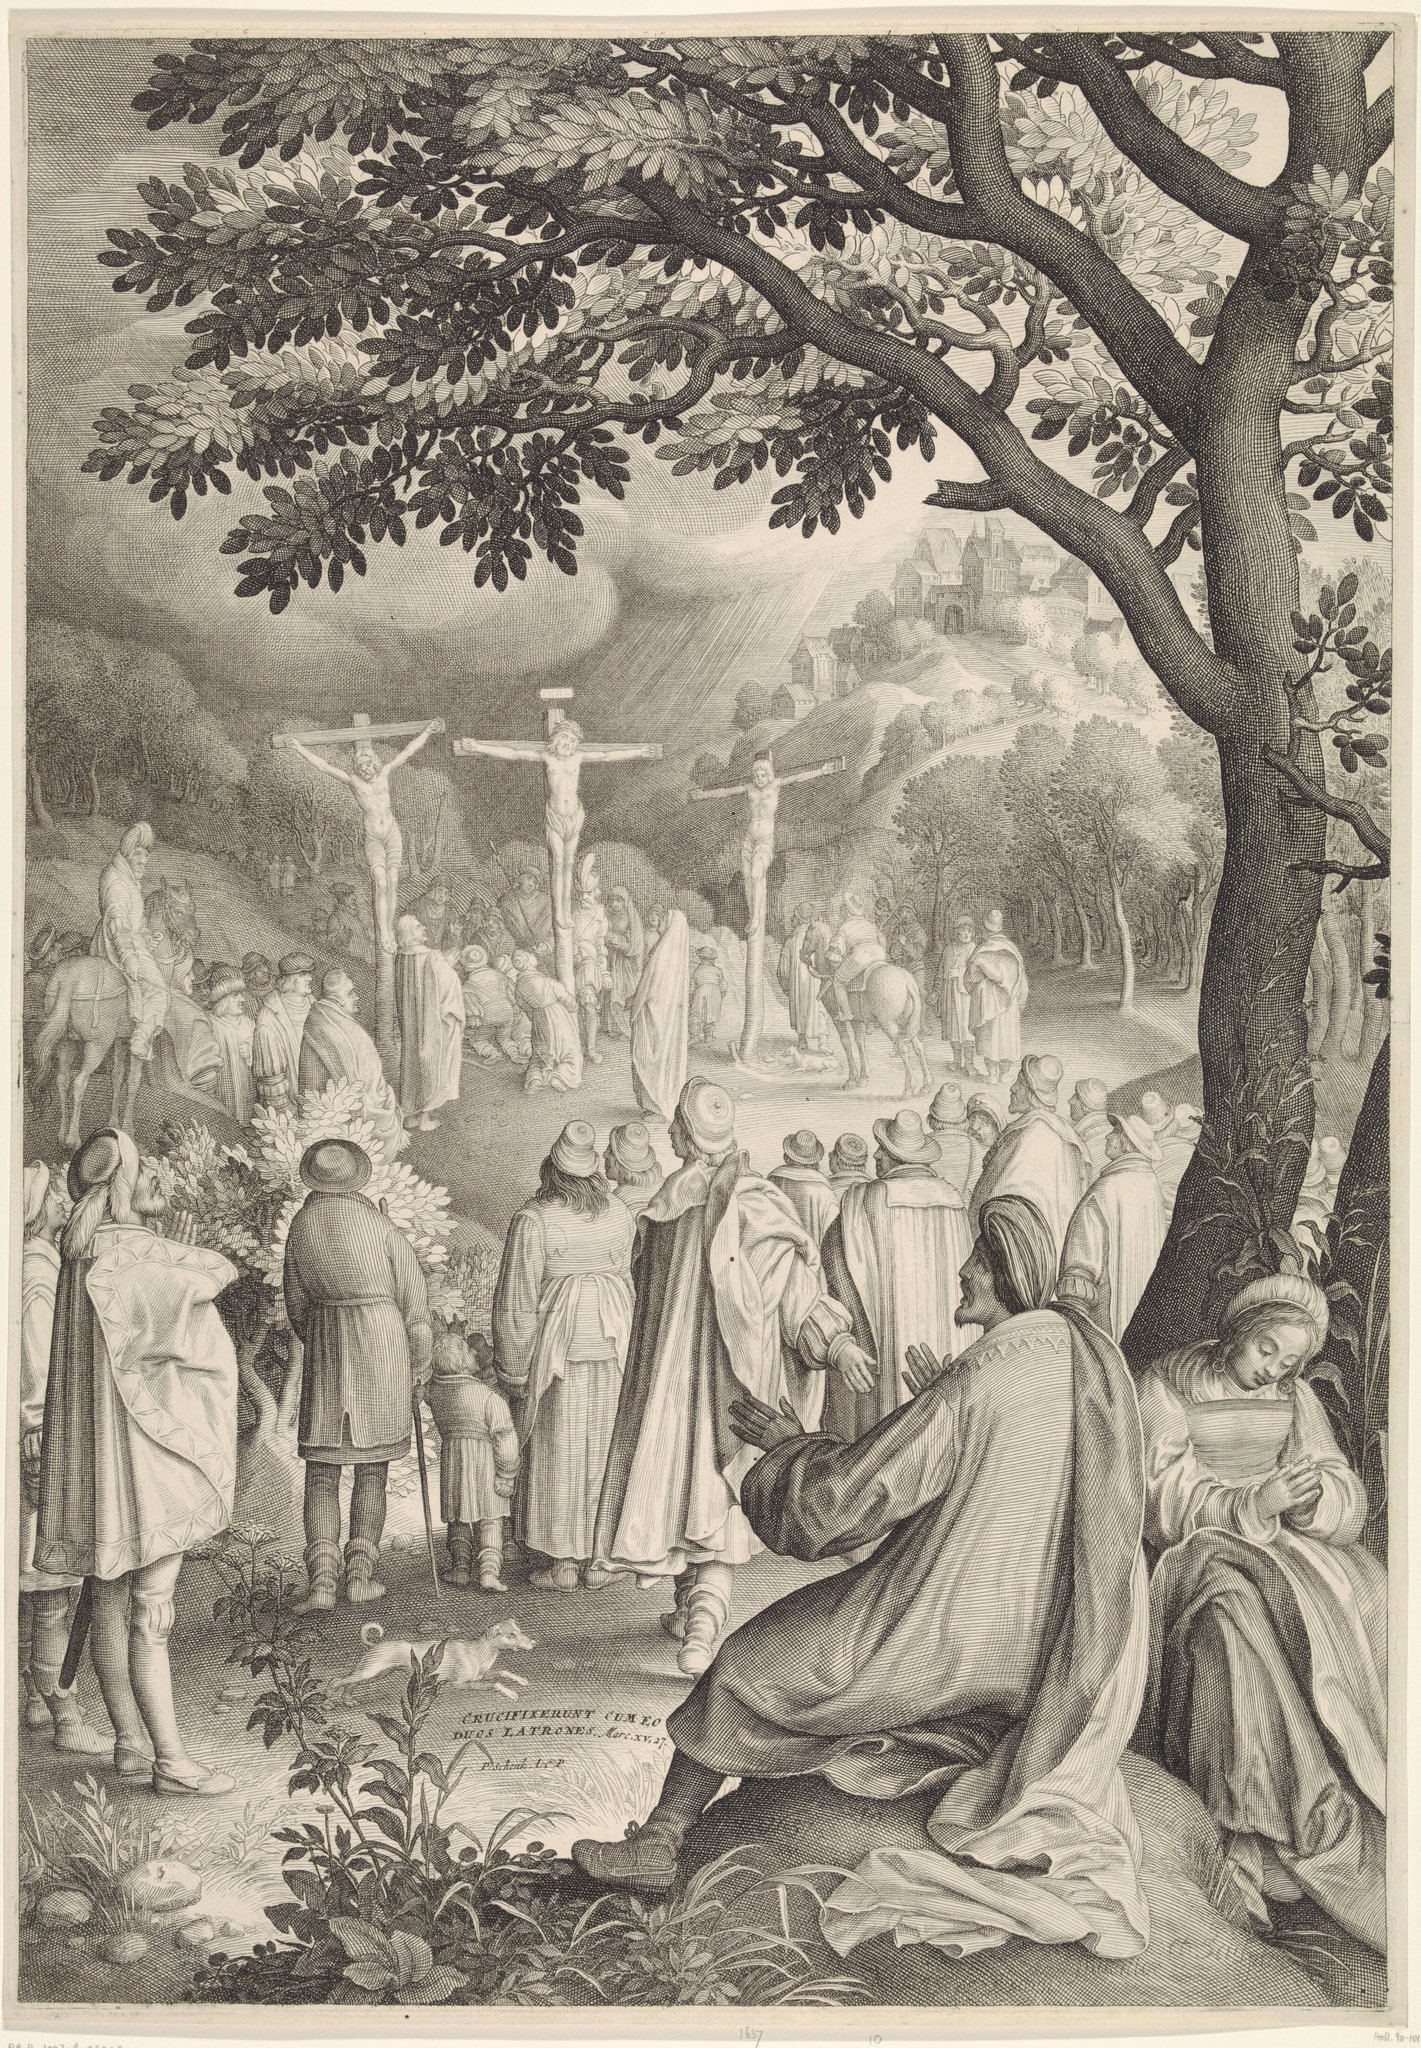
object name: print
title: Passie van Christus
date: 1637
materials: paper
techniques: engraving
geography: amsterdam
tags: crucified christ with mary, john, and mary magdalene, the crucifixion of christ: christ's death on the cross; golgotha (matthew 27:45-58; mark 15:33-45; luke 23:44-52; john 19:25-38)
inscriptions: date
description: De kruisdood van Christus op de berg Golgota. Links en rechts van hem de misdadigers die samen met hem gekruisigd zijn. Maria, Maria Magdalena en de apostel Johannes onder het kruis.